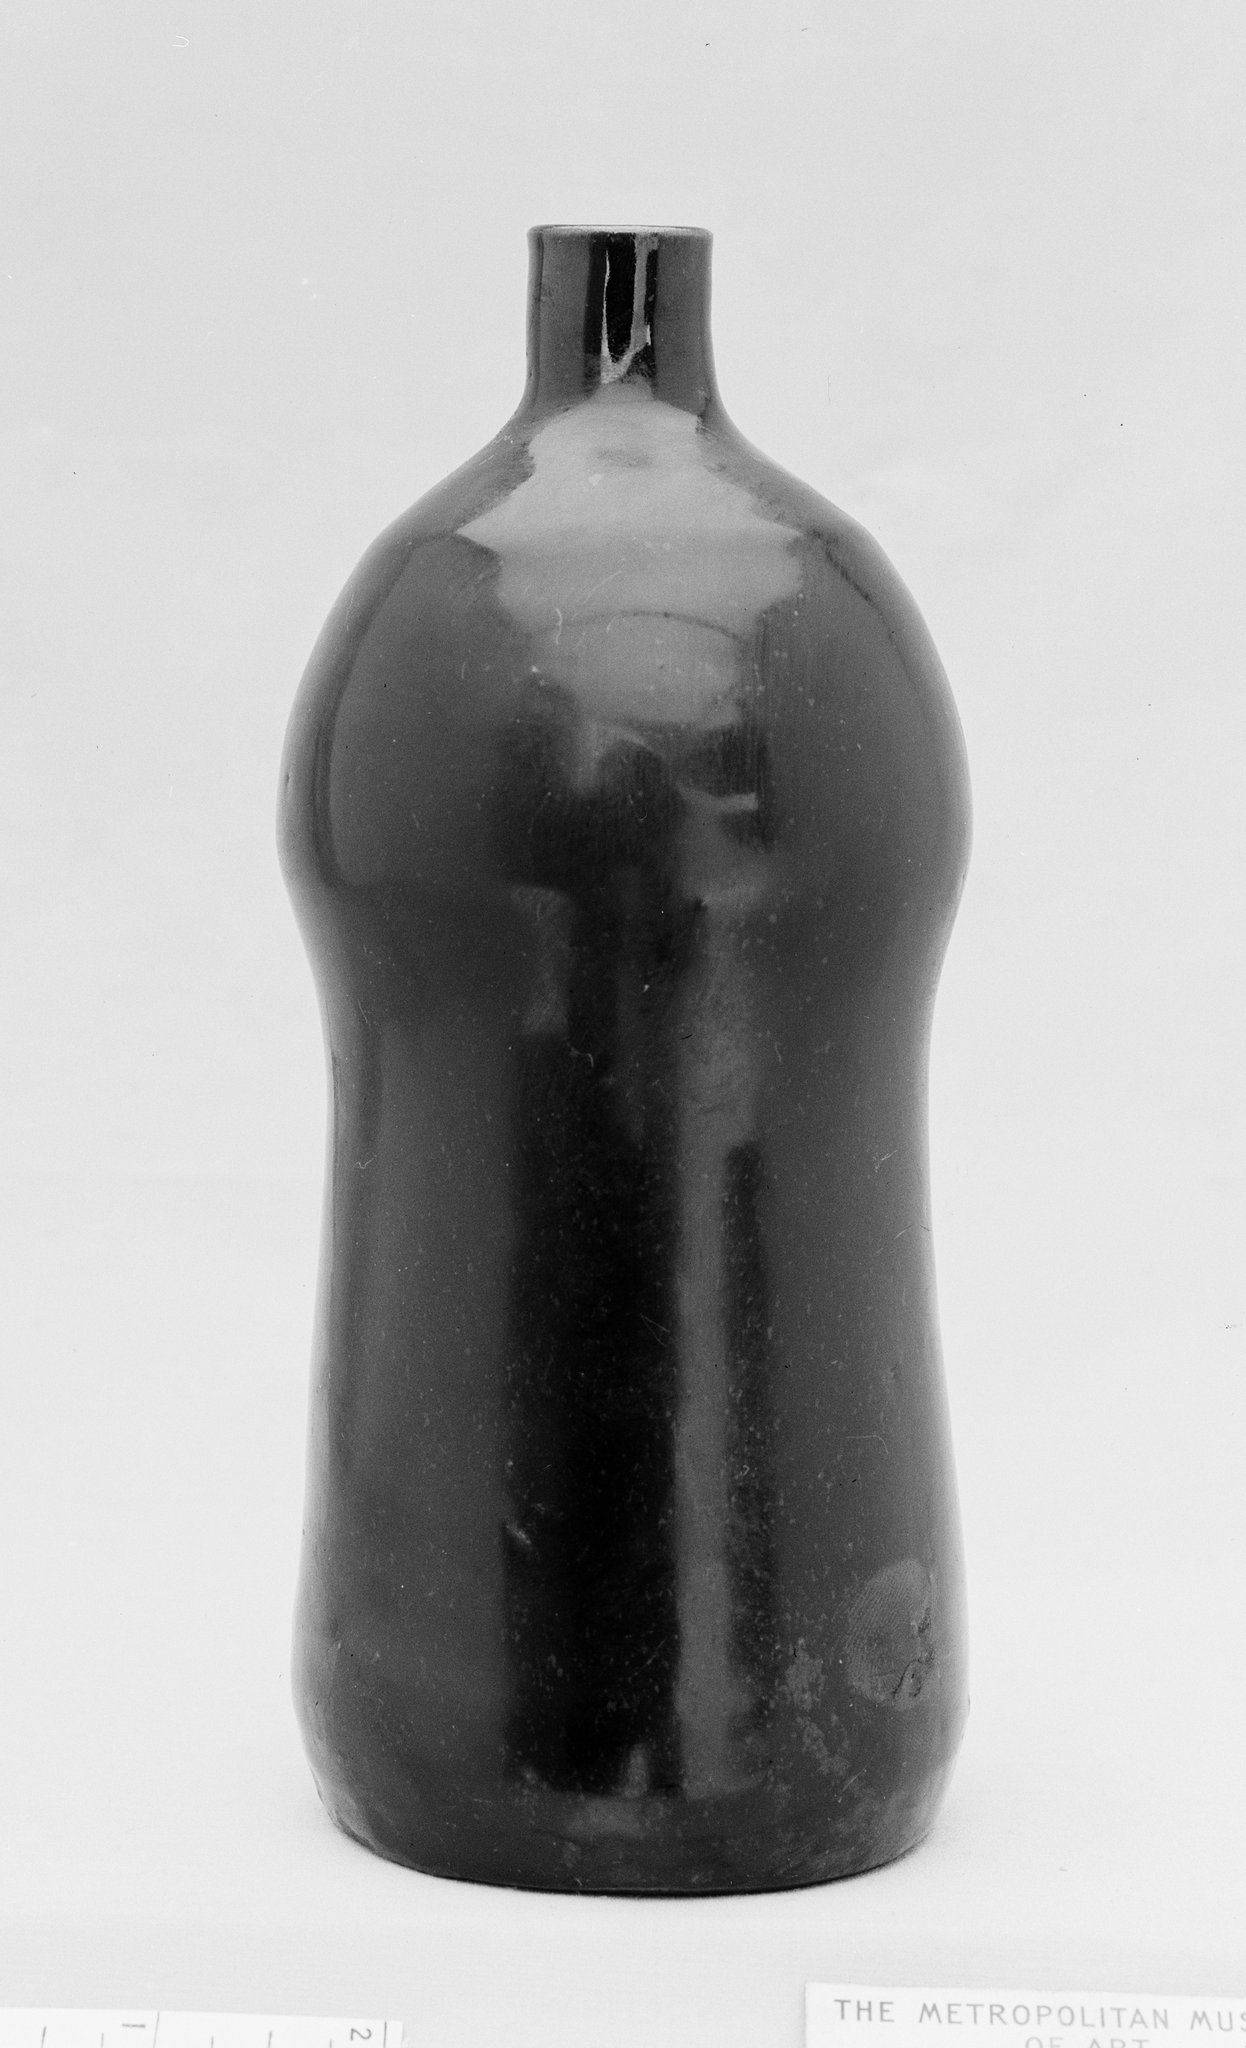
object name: wine bottle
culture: japanese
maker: masamoto naosaku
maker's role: artist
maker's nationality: japanese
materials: clay, glaze